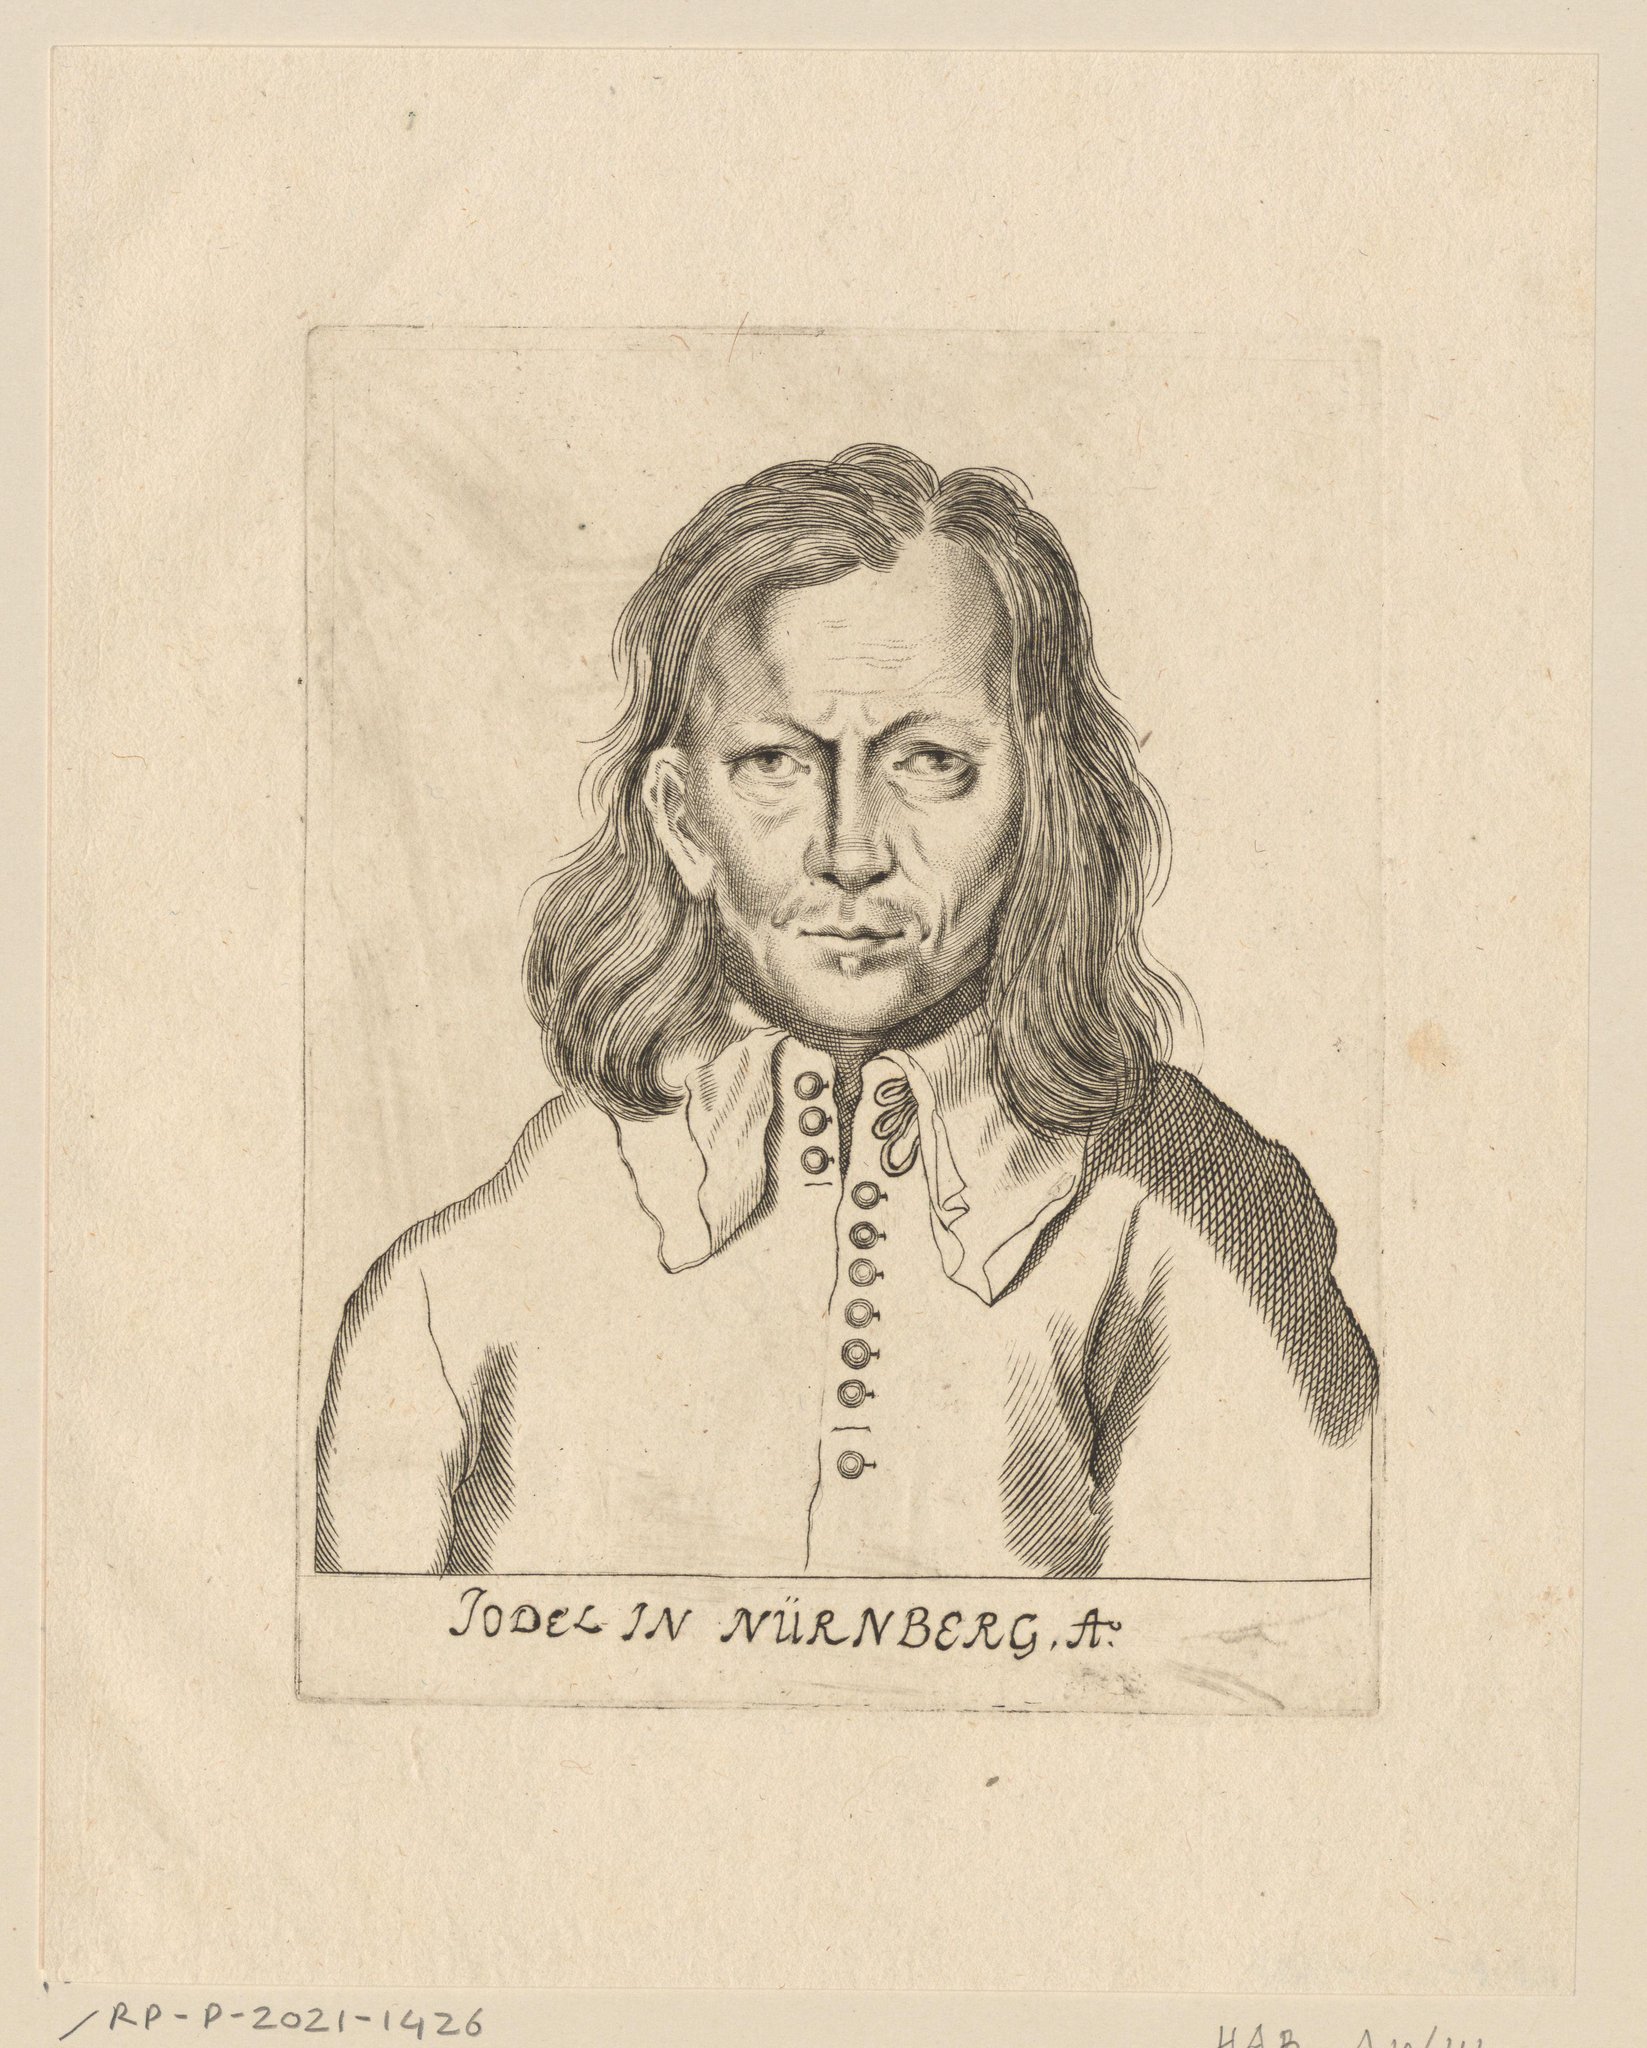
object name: print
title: Portret van N.N. Jodel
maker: Anonymous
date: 1750-1799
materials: paper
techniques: engraving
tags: historical persons